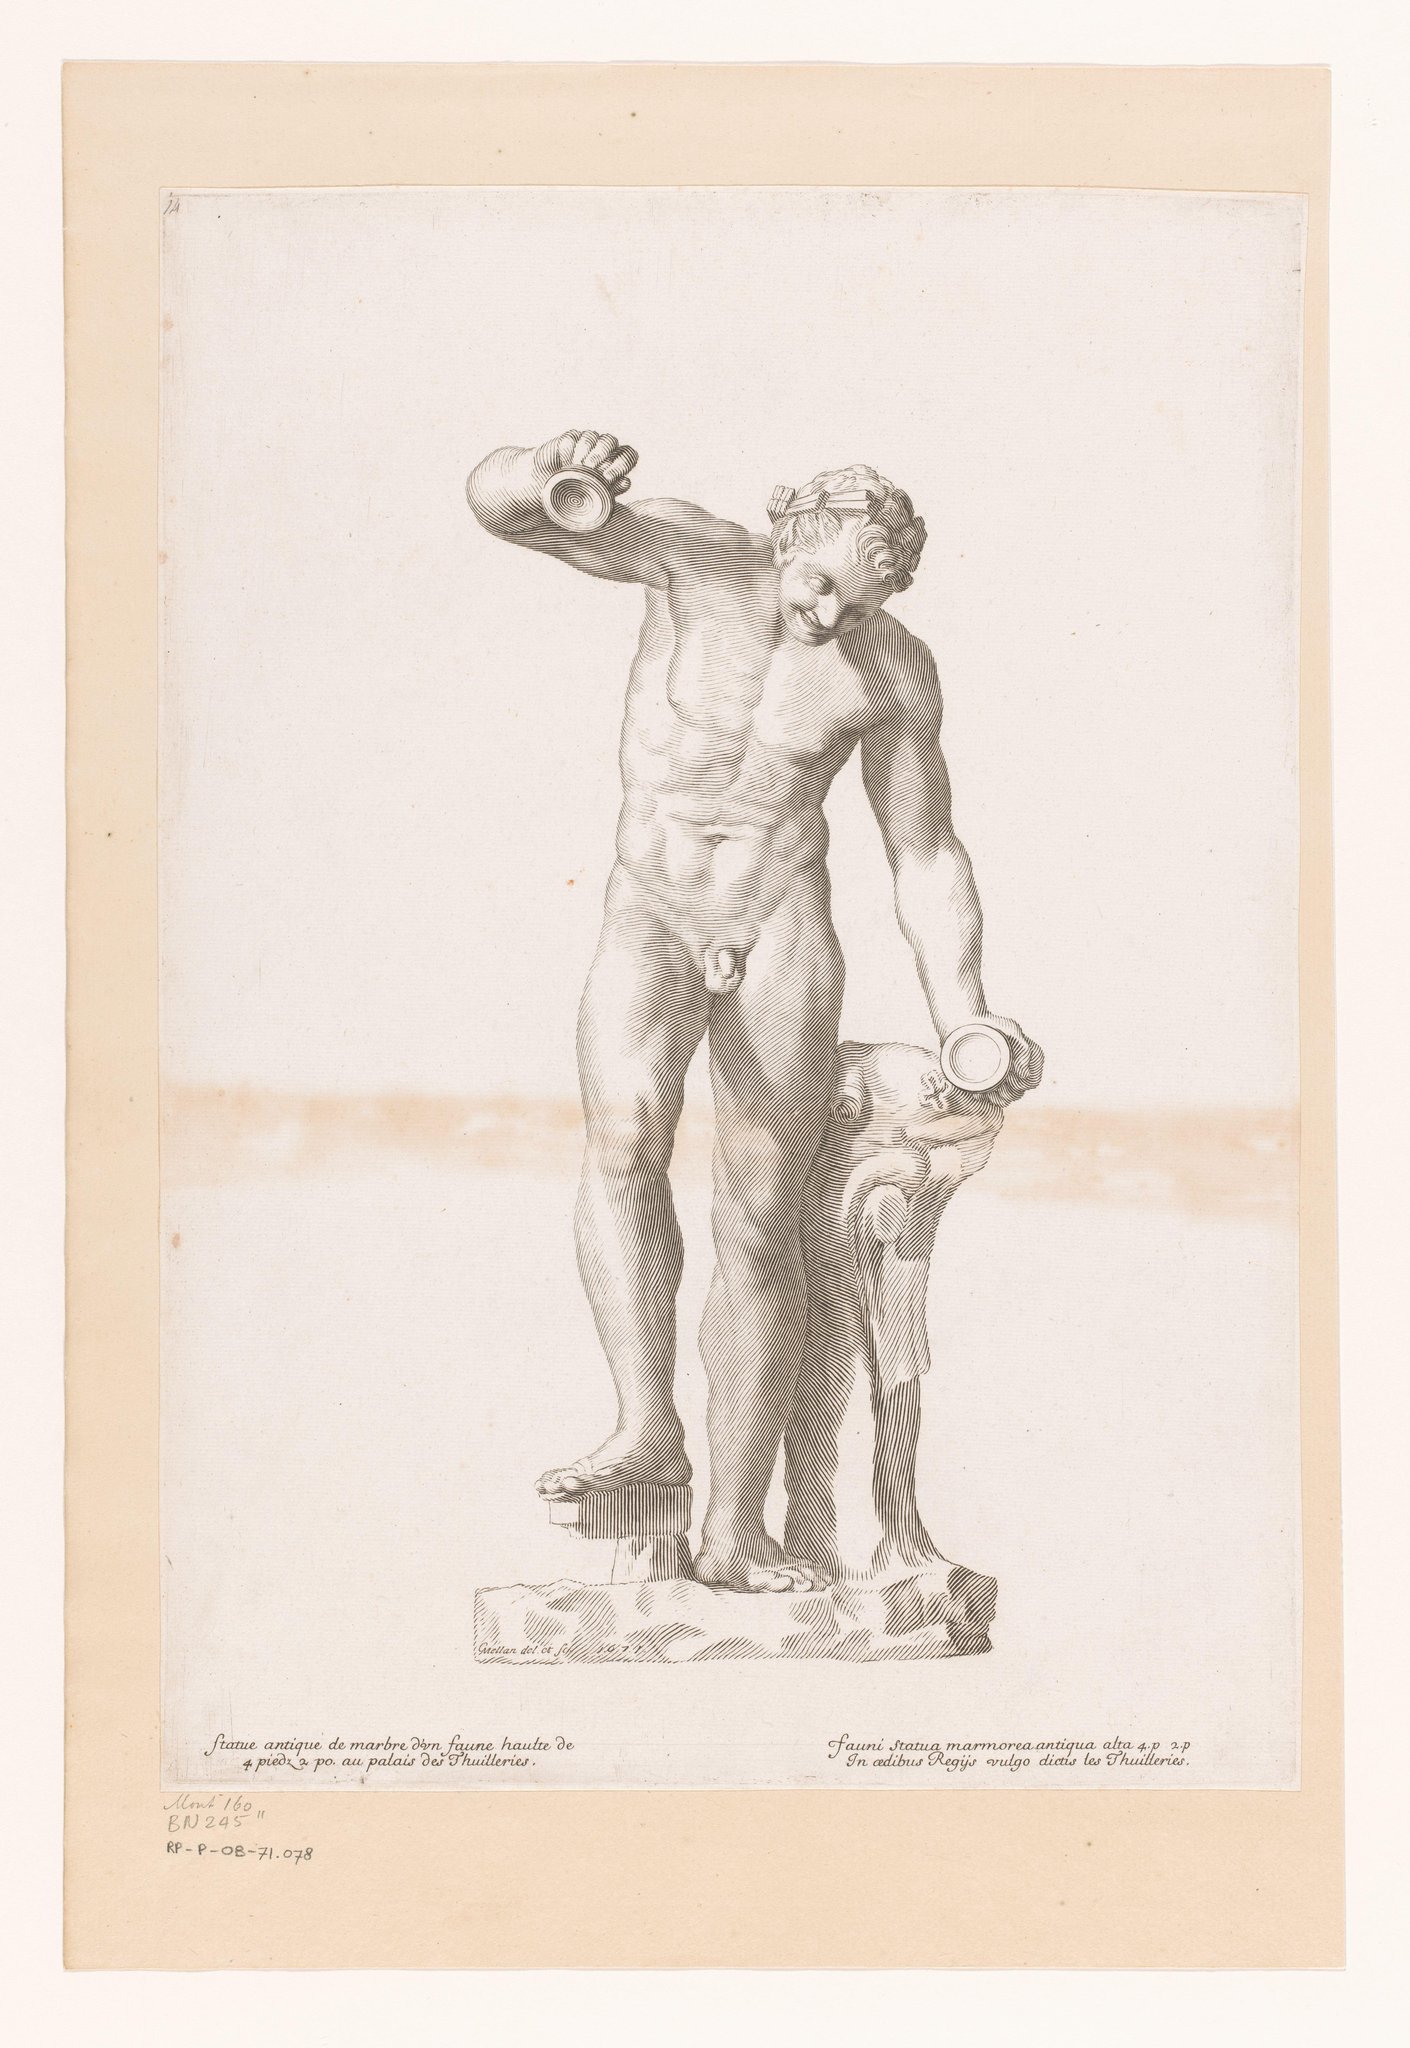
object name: book illustration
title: Standbeeld van een faun met cymbalen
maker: claude mellan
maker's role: draughtsman, print maker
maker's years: 1598-1688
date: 1671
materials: paper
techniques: engraving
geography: france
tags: satyrs, fauns, sileni, piece of sculpture, reproduction of a piece of sculpture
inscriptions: collector's mark: Lugt 240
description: Prent gebruikt voor: Félibien, André. Tableaux du Cabinet du roy. Statues et bustes antiques des maisons royales. Parijs: Imprimerie Royale, 1677. Het boek bevat 61 prenten van beelden en bustes uit Franse koninklijke collectie. Mellan vervaardigde in totaal achttien platen (zie ook British Museum, inv.nr. 1874,0808.1488). De verblijfplaats van het beeld is onbekend.